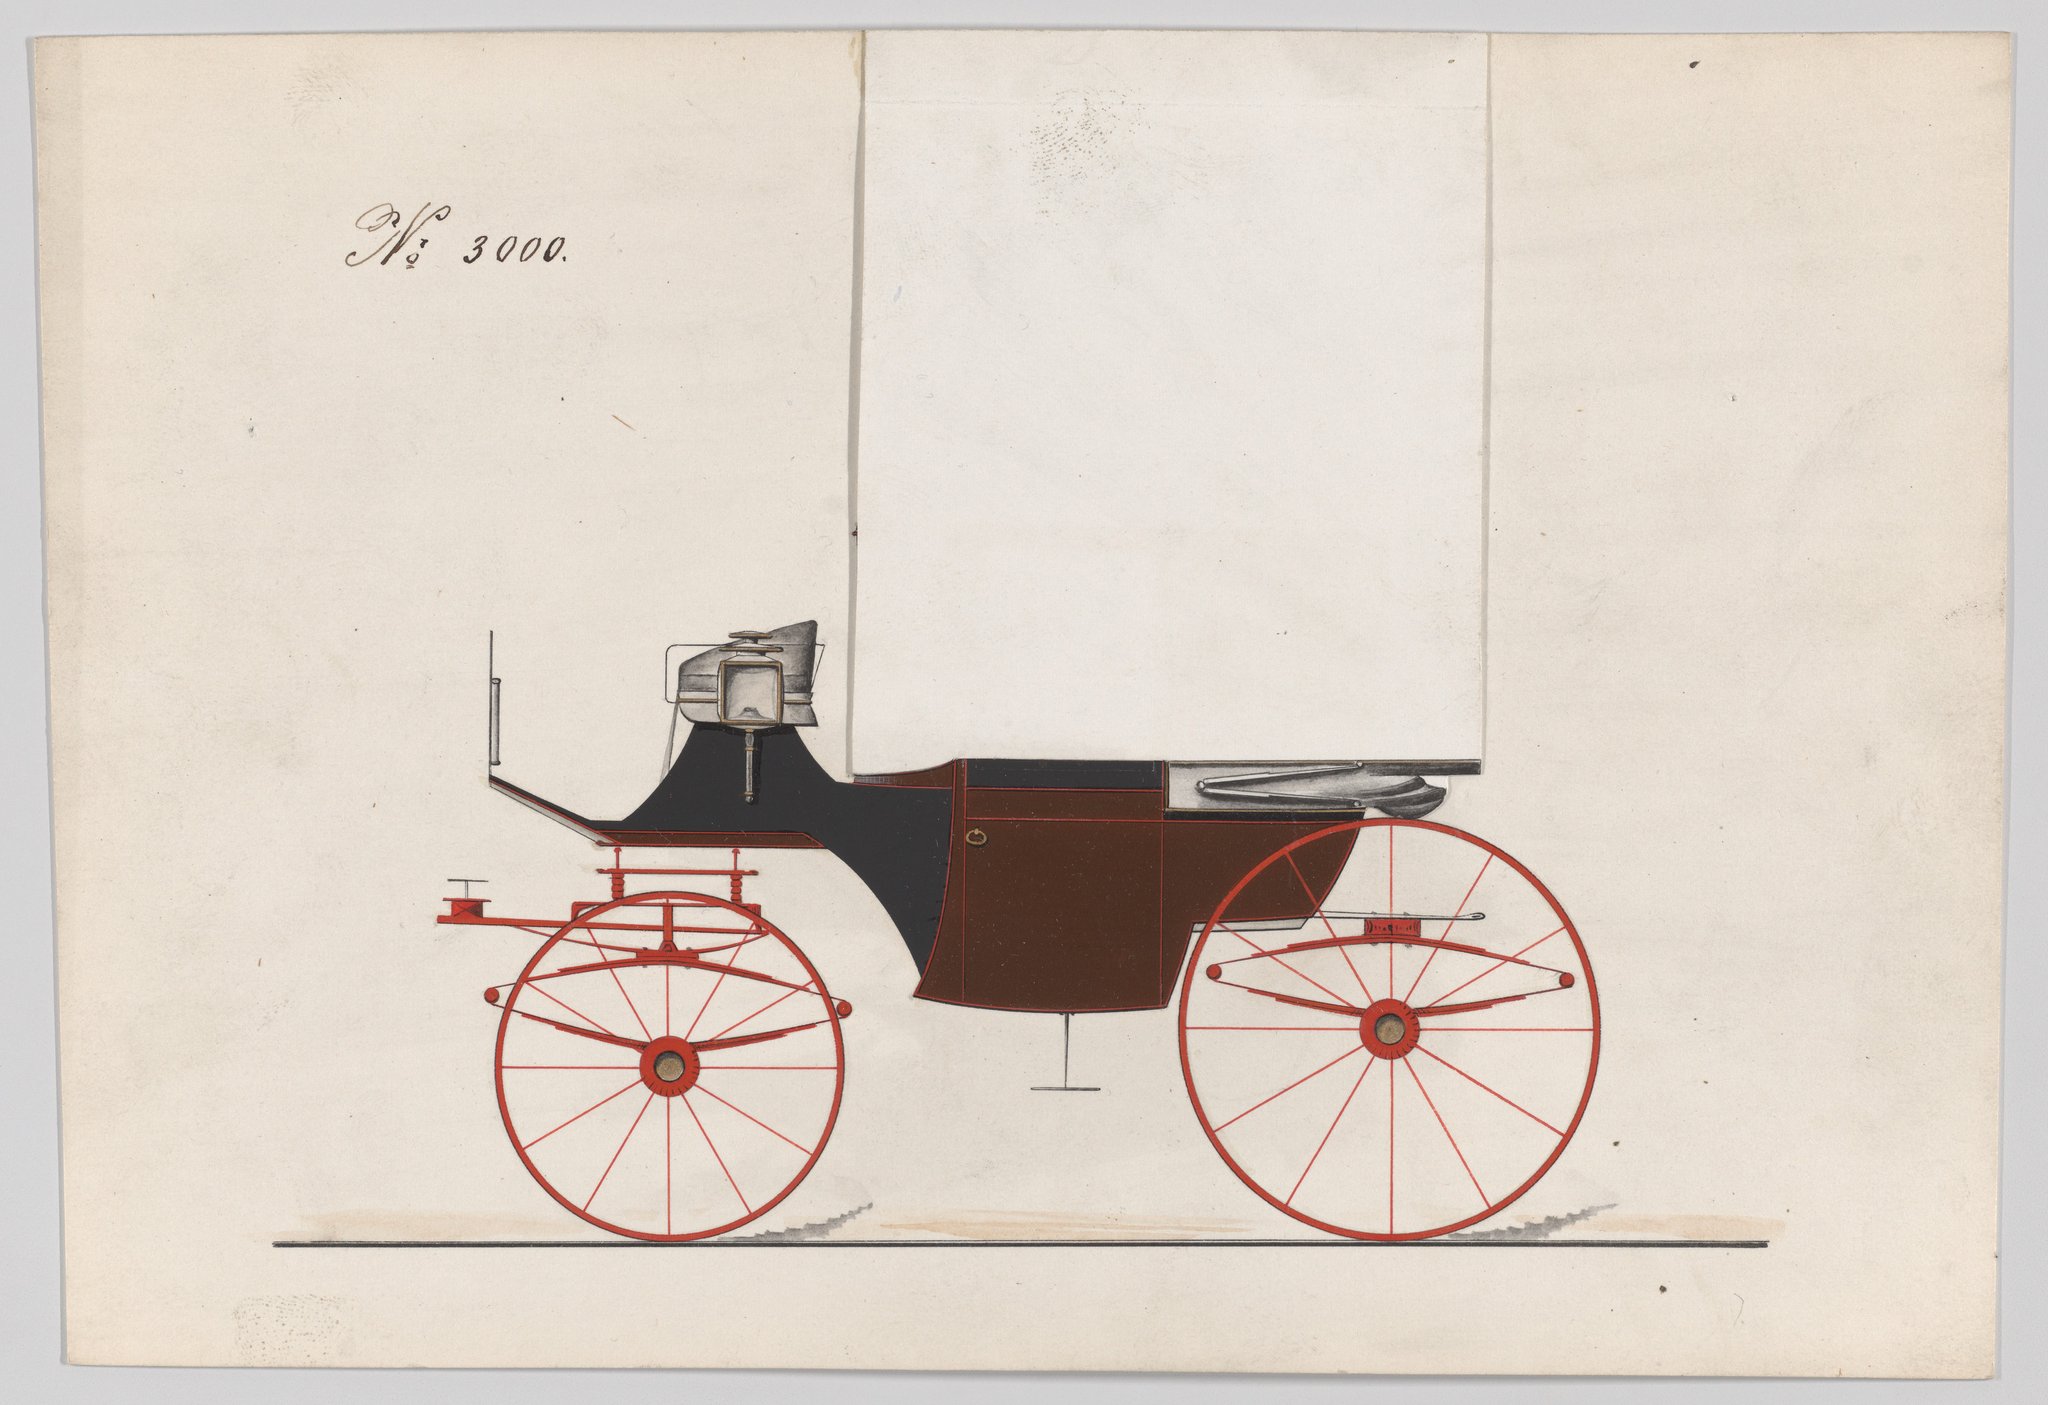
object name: drawing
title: Design for Landaulet, no. 3000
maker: brewster & co.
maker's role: manufacturer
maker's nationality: american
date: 1874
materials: gouache, gum arabic, ink, watercolor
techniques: pen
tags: carriages